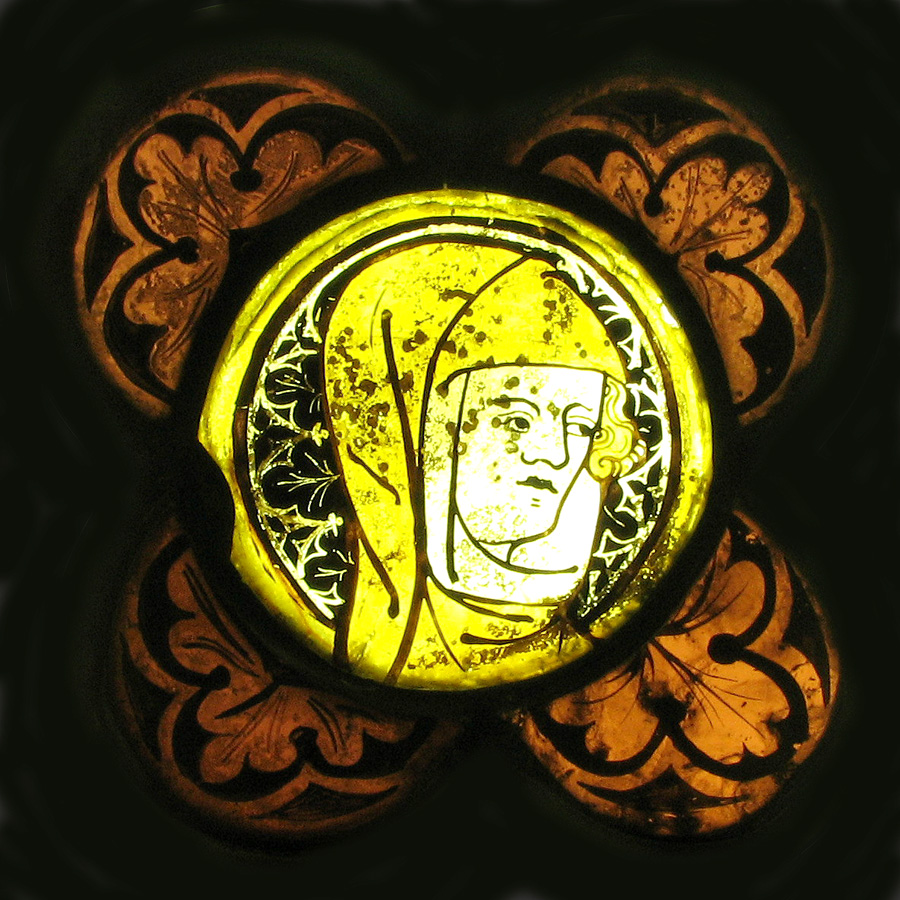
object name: panel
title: Head of a Woman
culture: french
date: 1301-1400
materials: glass, metal, paint, pigment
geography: rouen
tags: heads